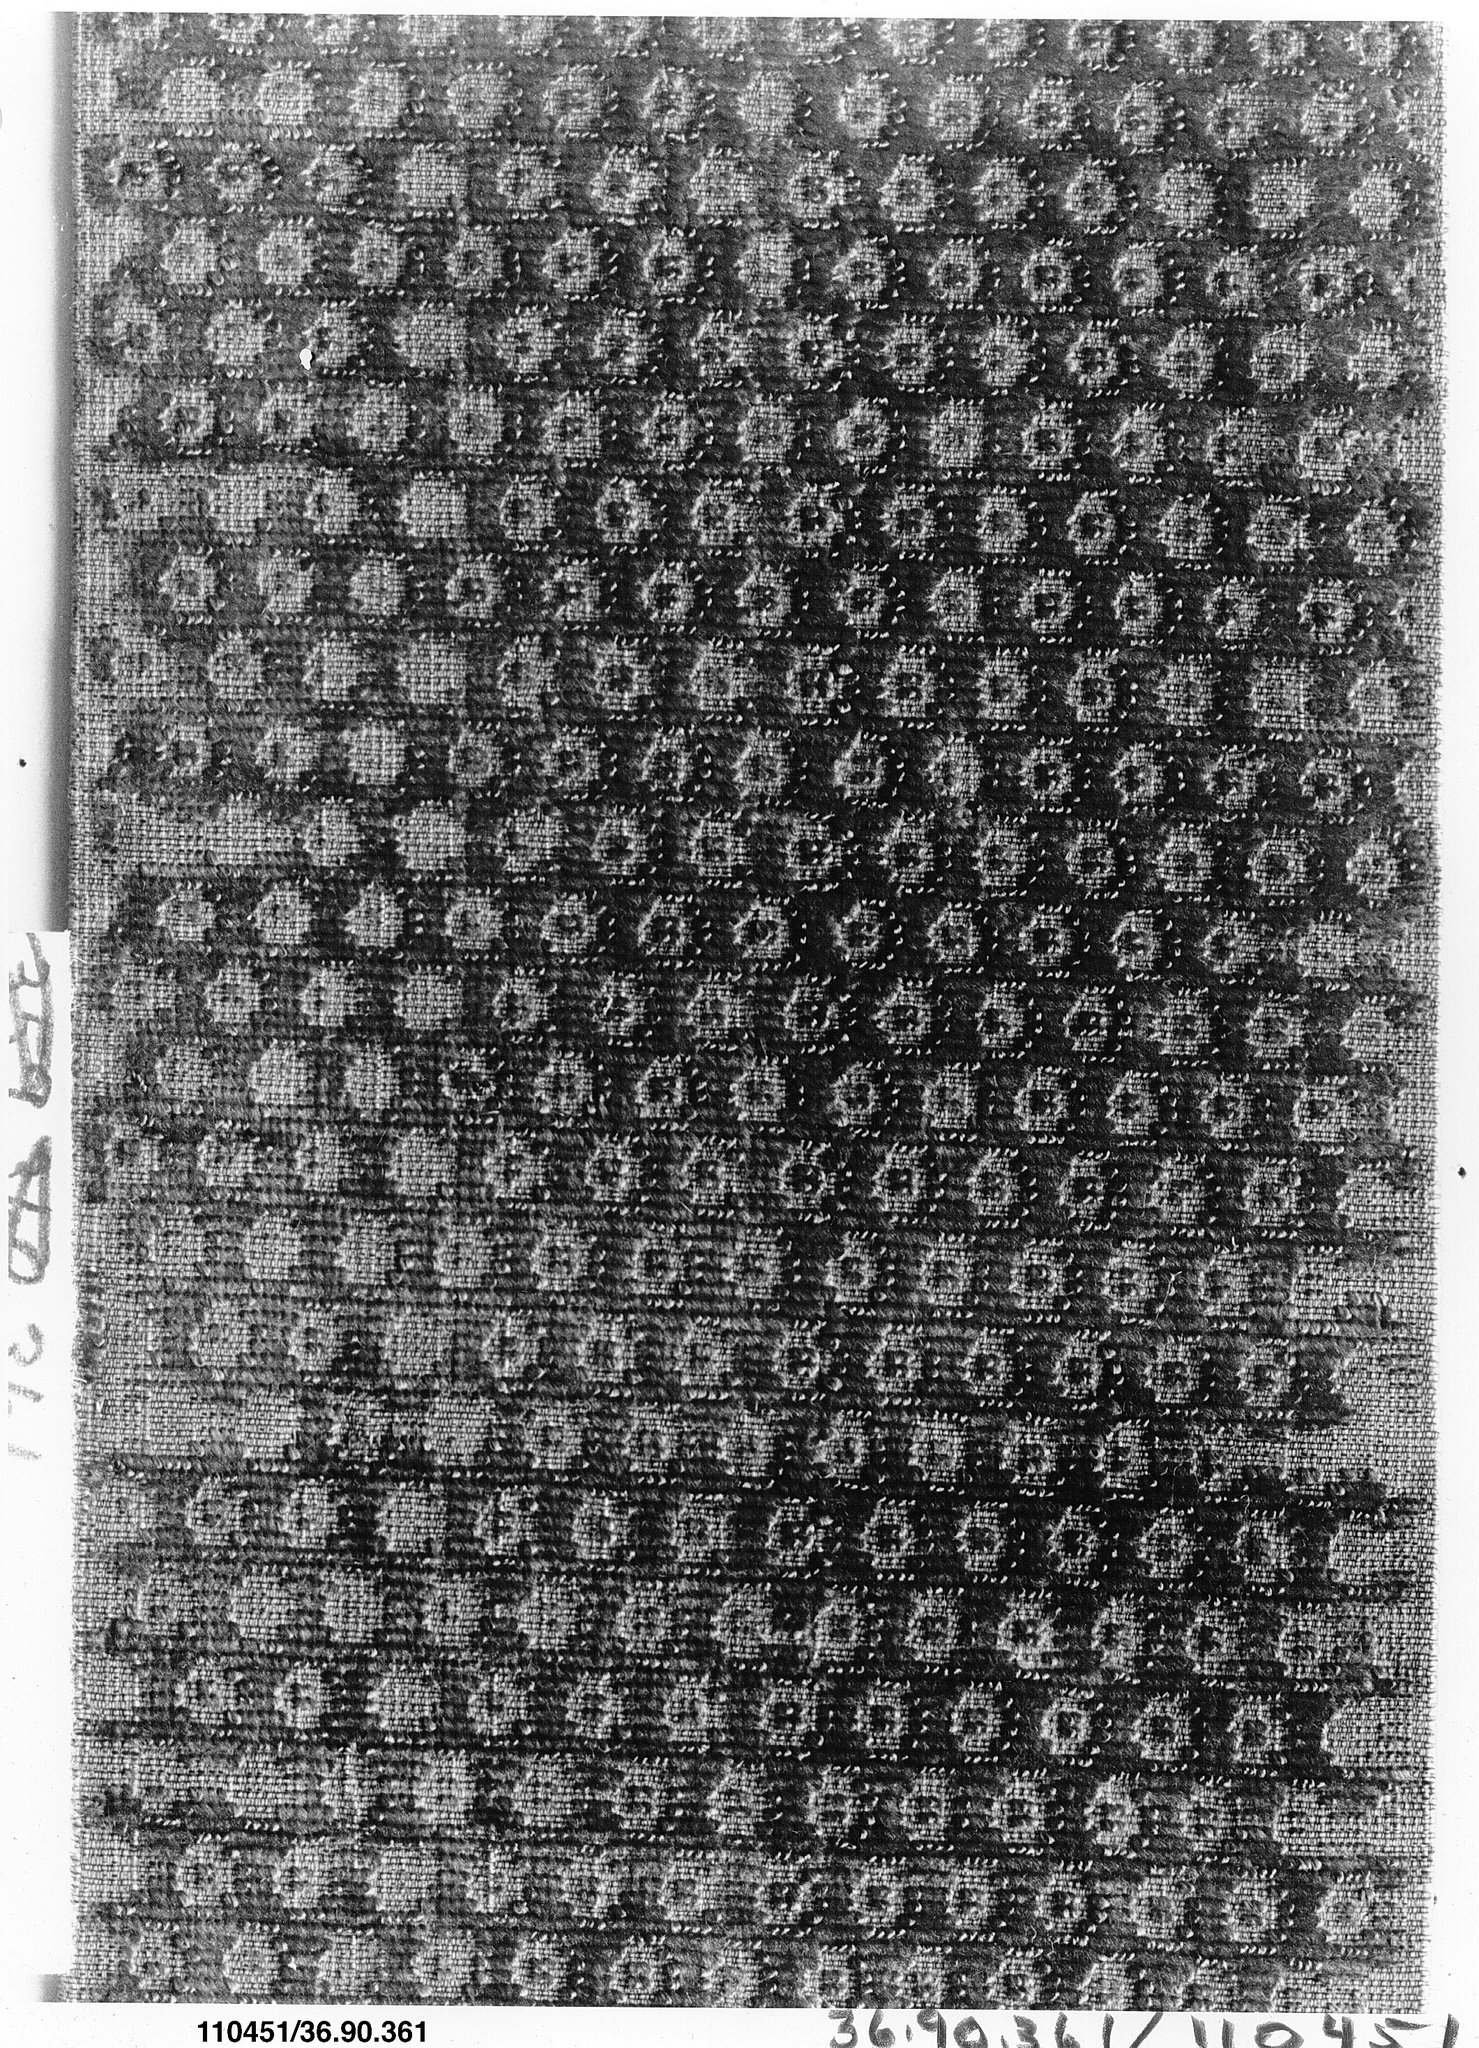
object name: piece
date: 1501-1700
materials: silk